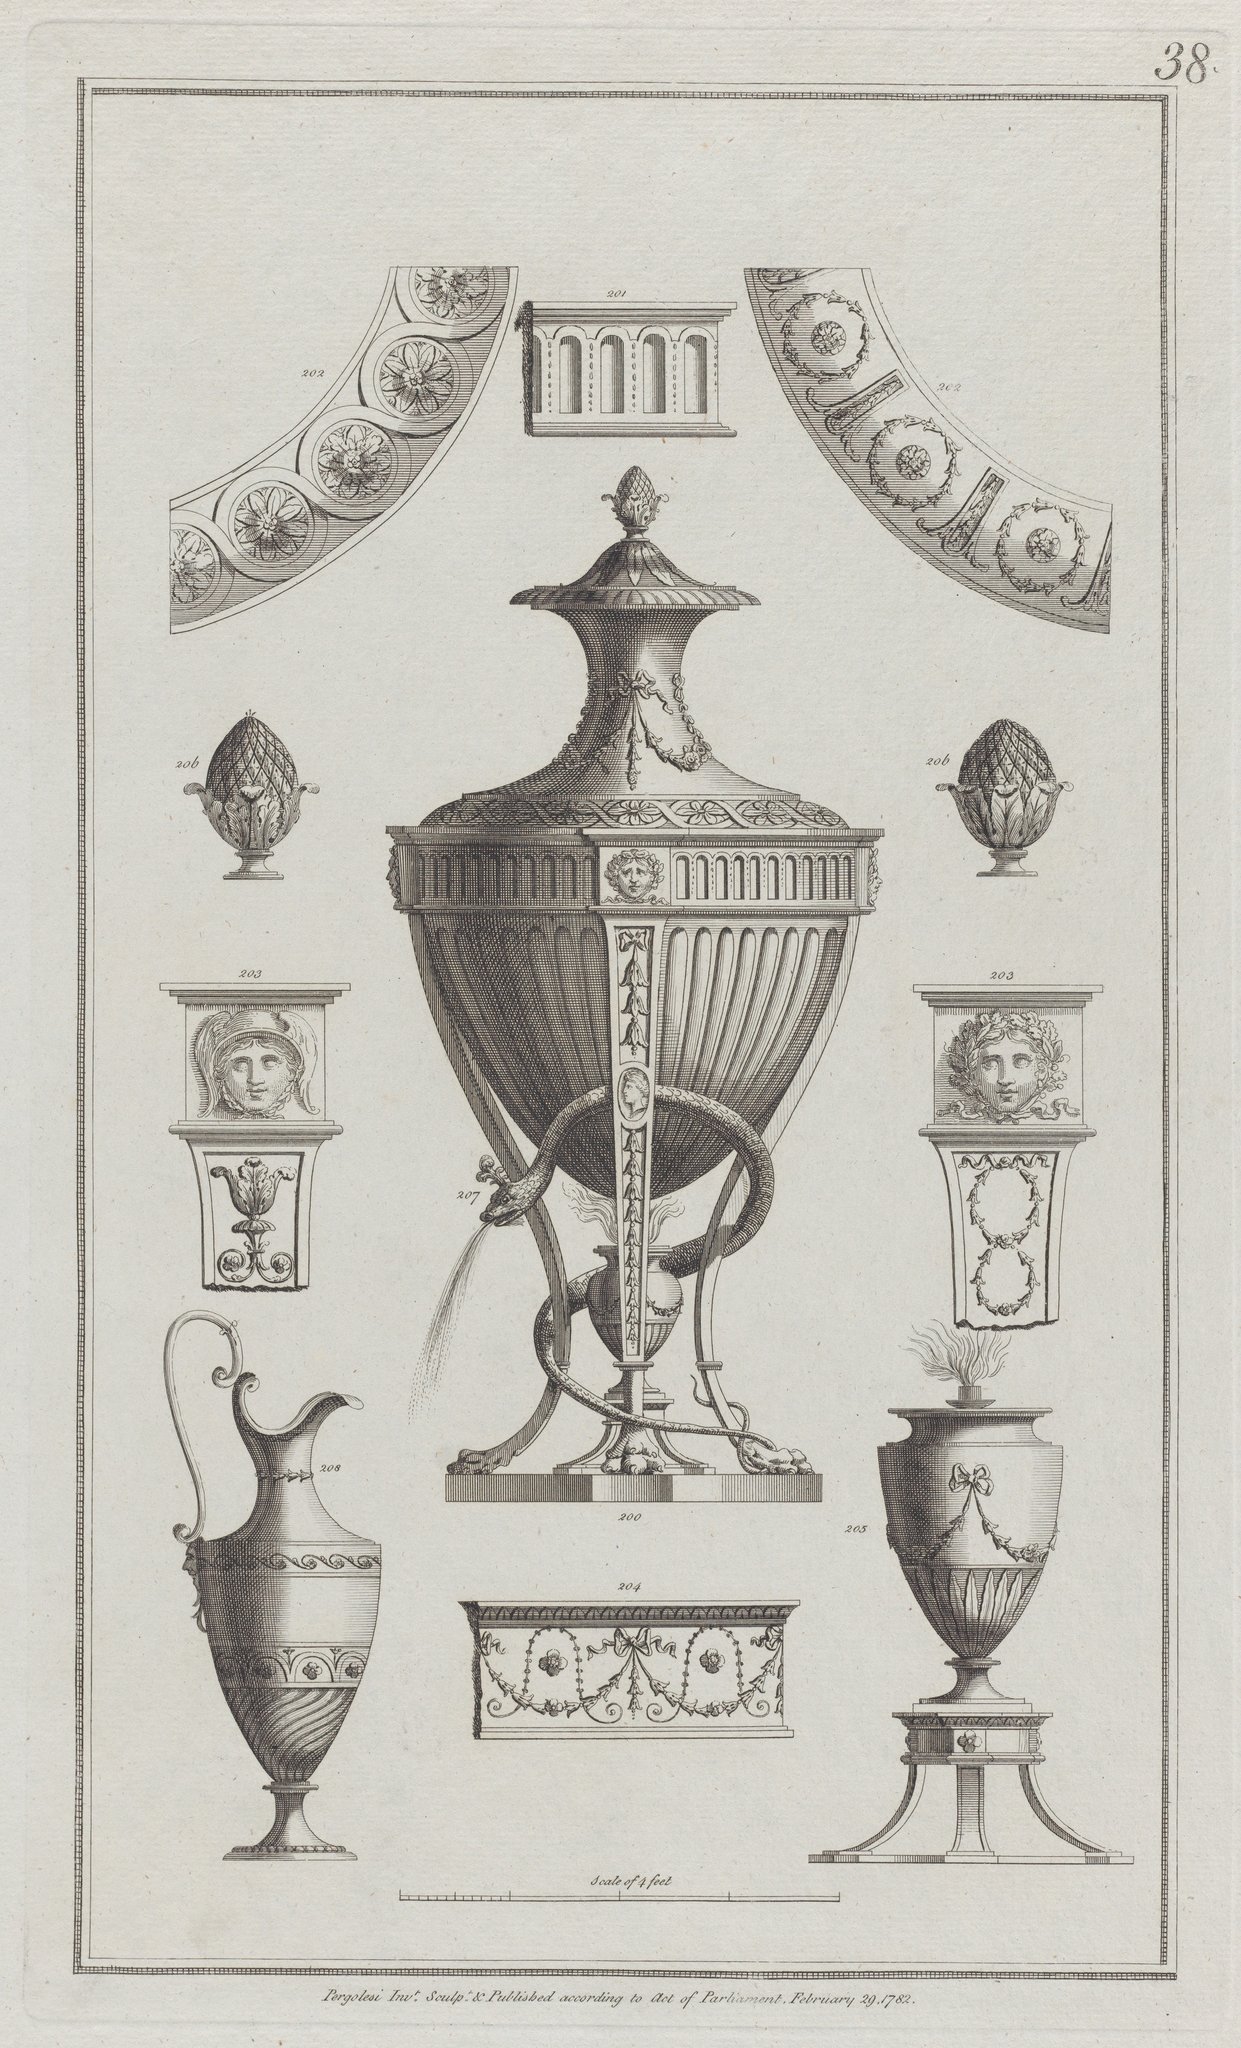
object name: print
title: Vases and Ornament Designs, nos. 200-208, plate 38 from "Designs for Various Ornaments"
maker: michelangelo pergolesi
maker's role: artist and publisher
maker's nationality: italian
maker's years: 1760-1801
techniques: etching